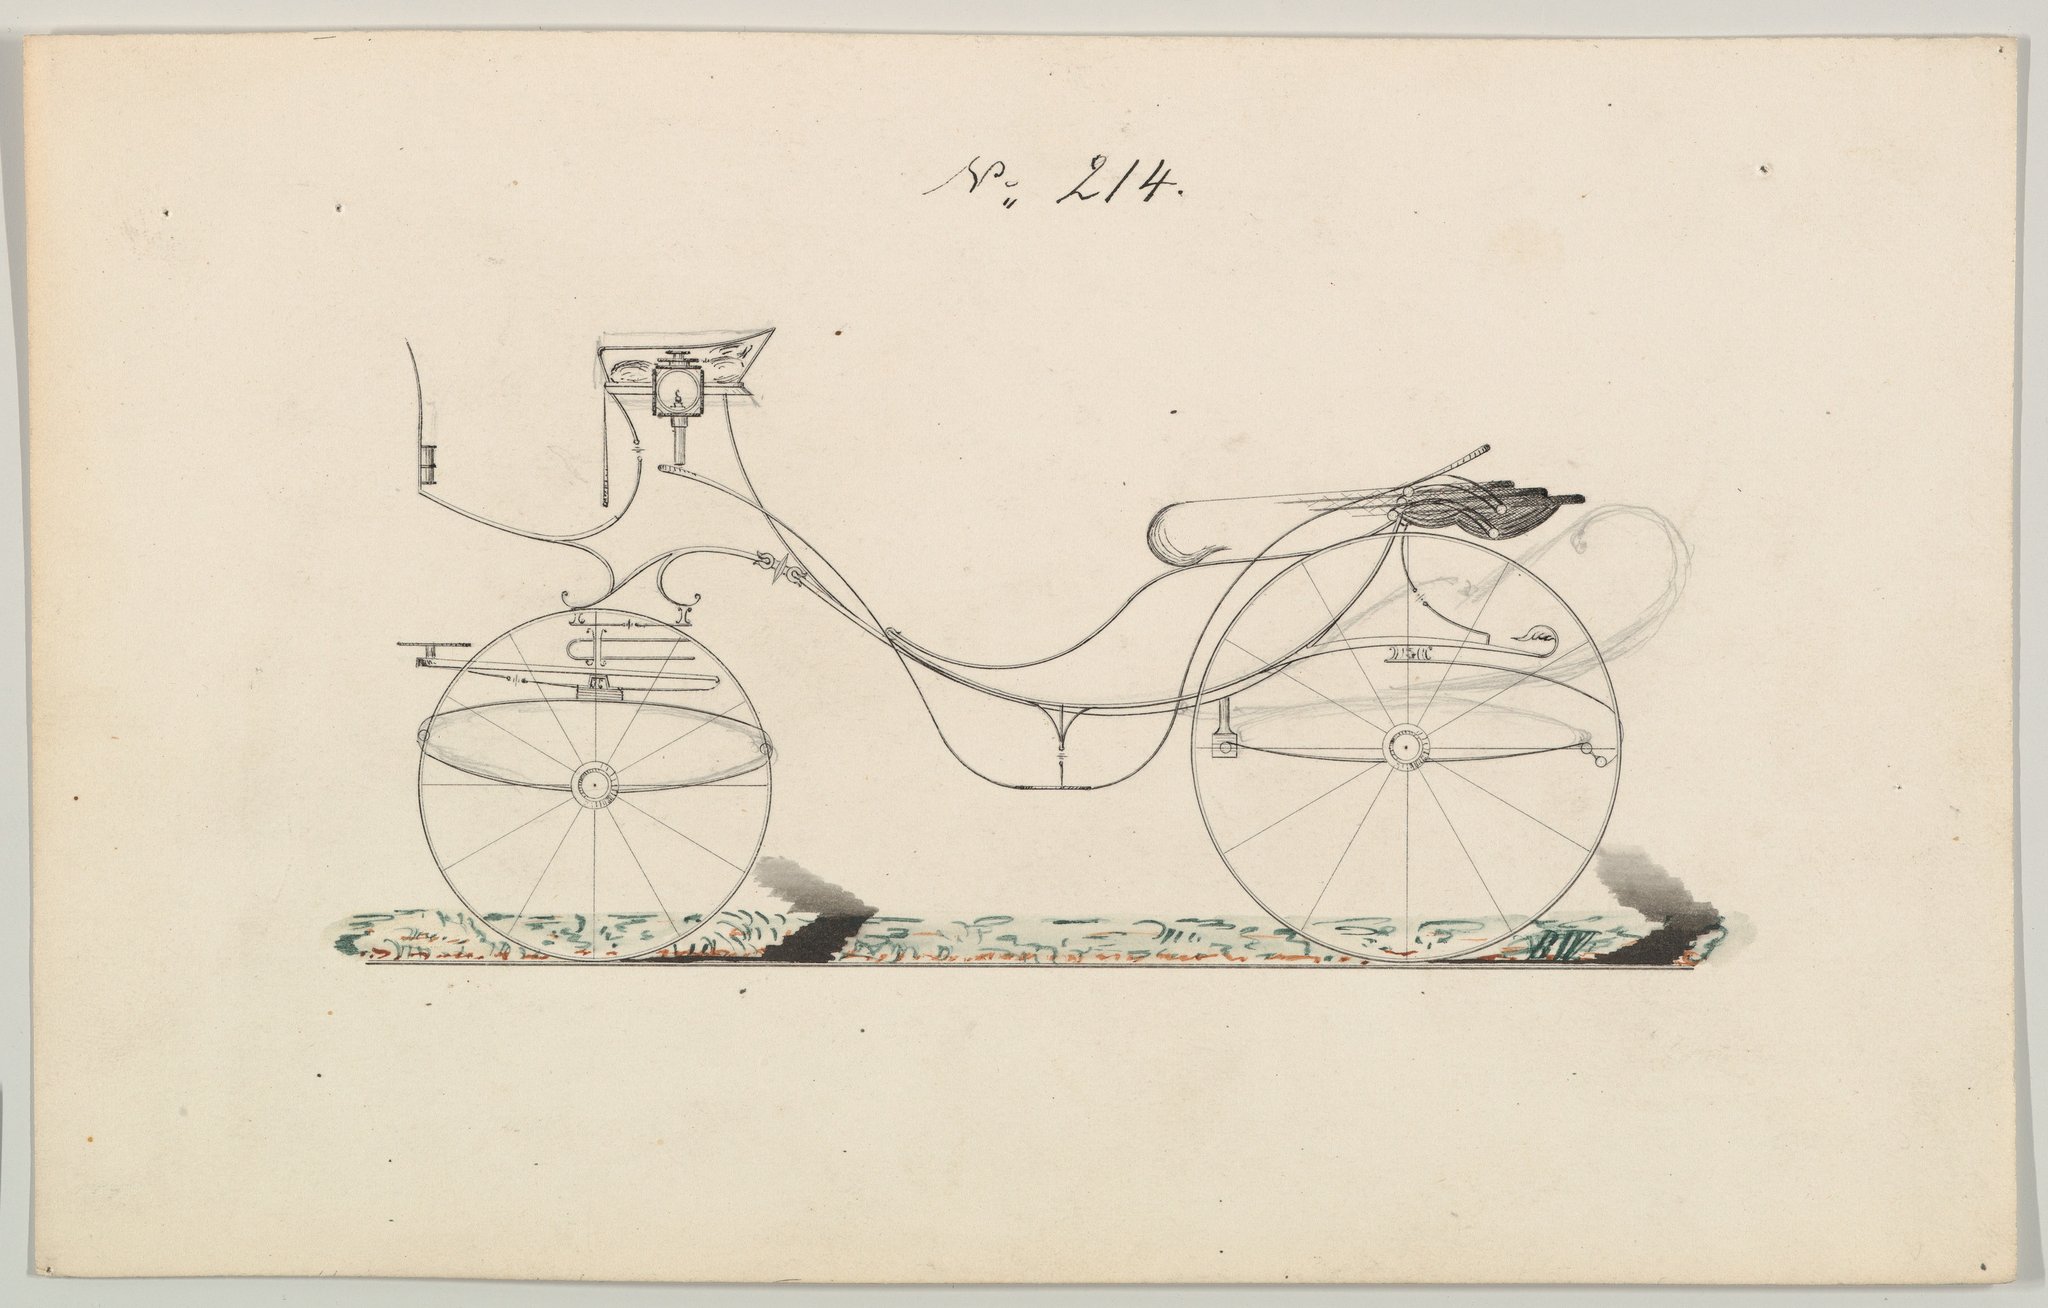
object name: drawing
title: Cabriolet Victoria # 214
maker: brewster & co.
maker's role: manufacturer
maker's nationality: american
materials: gouache, graphite, ink, watercolor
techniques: pen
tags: carriages